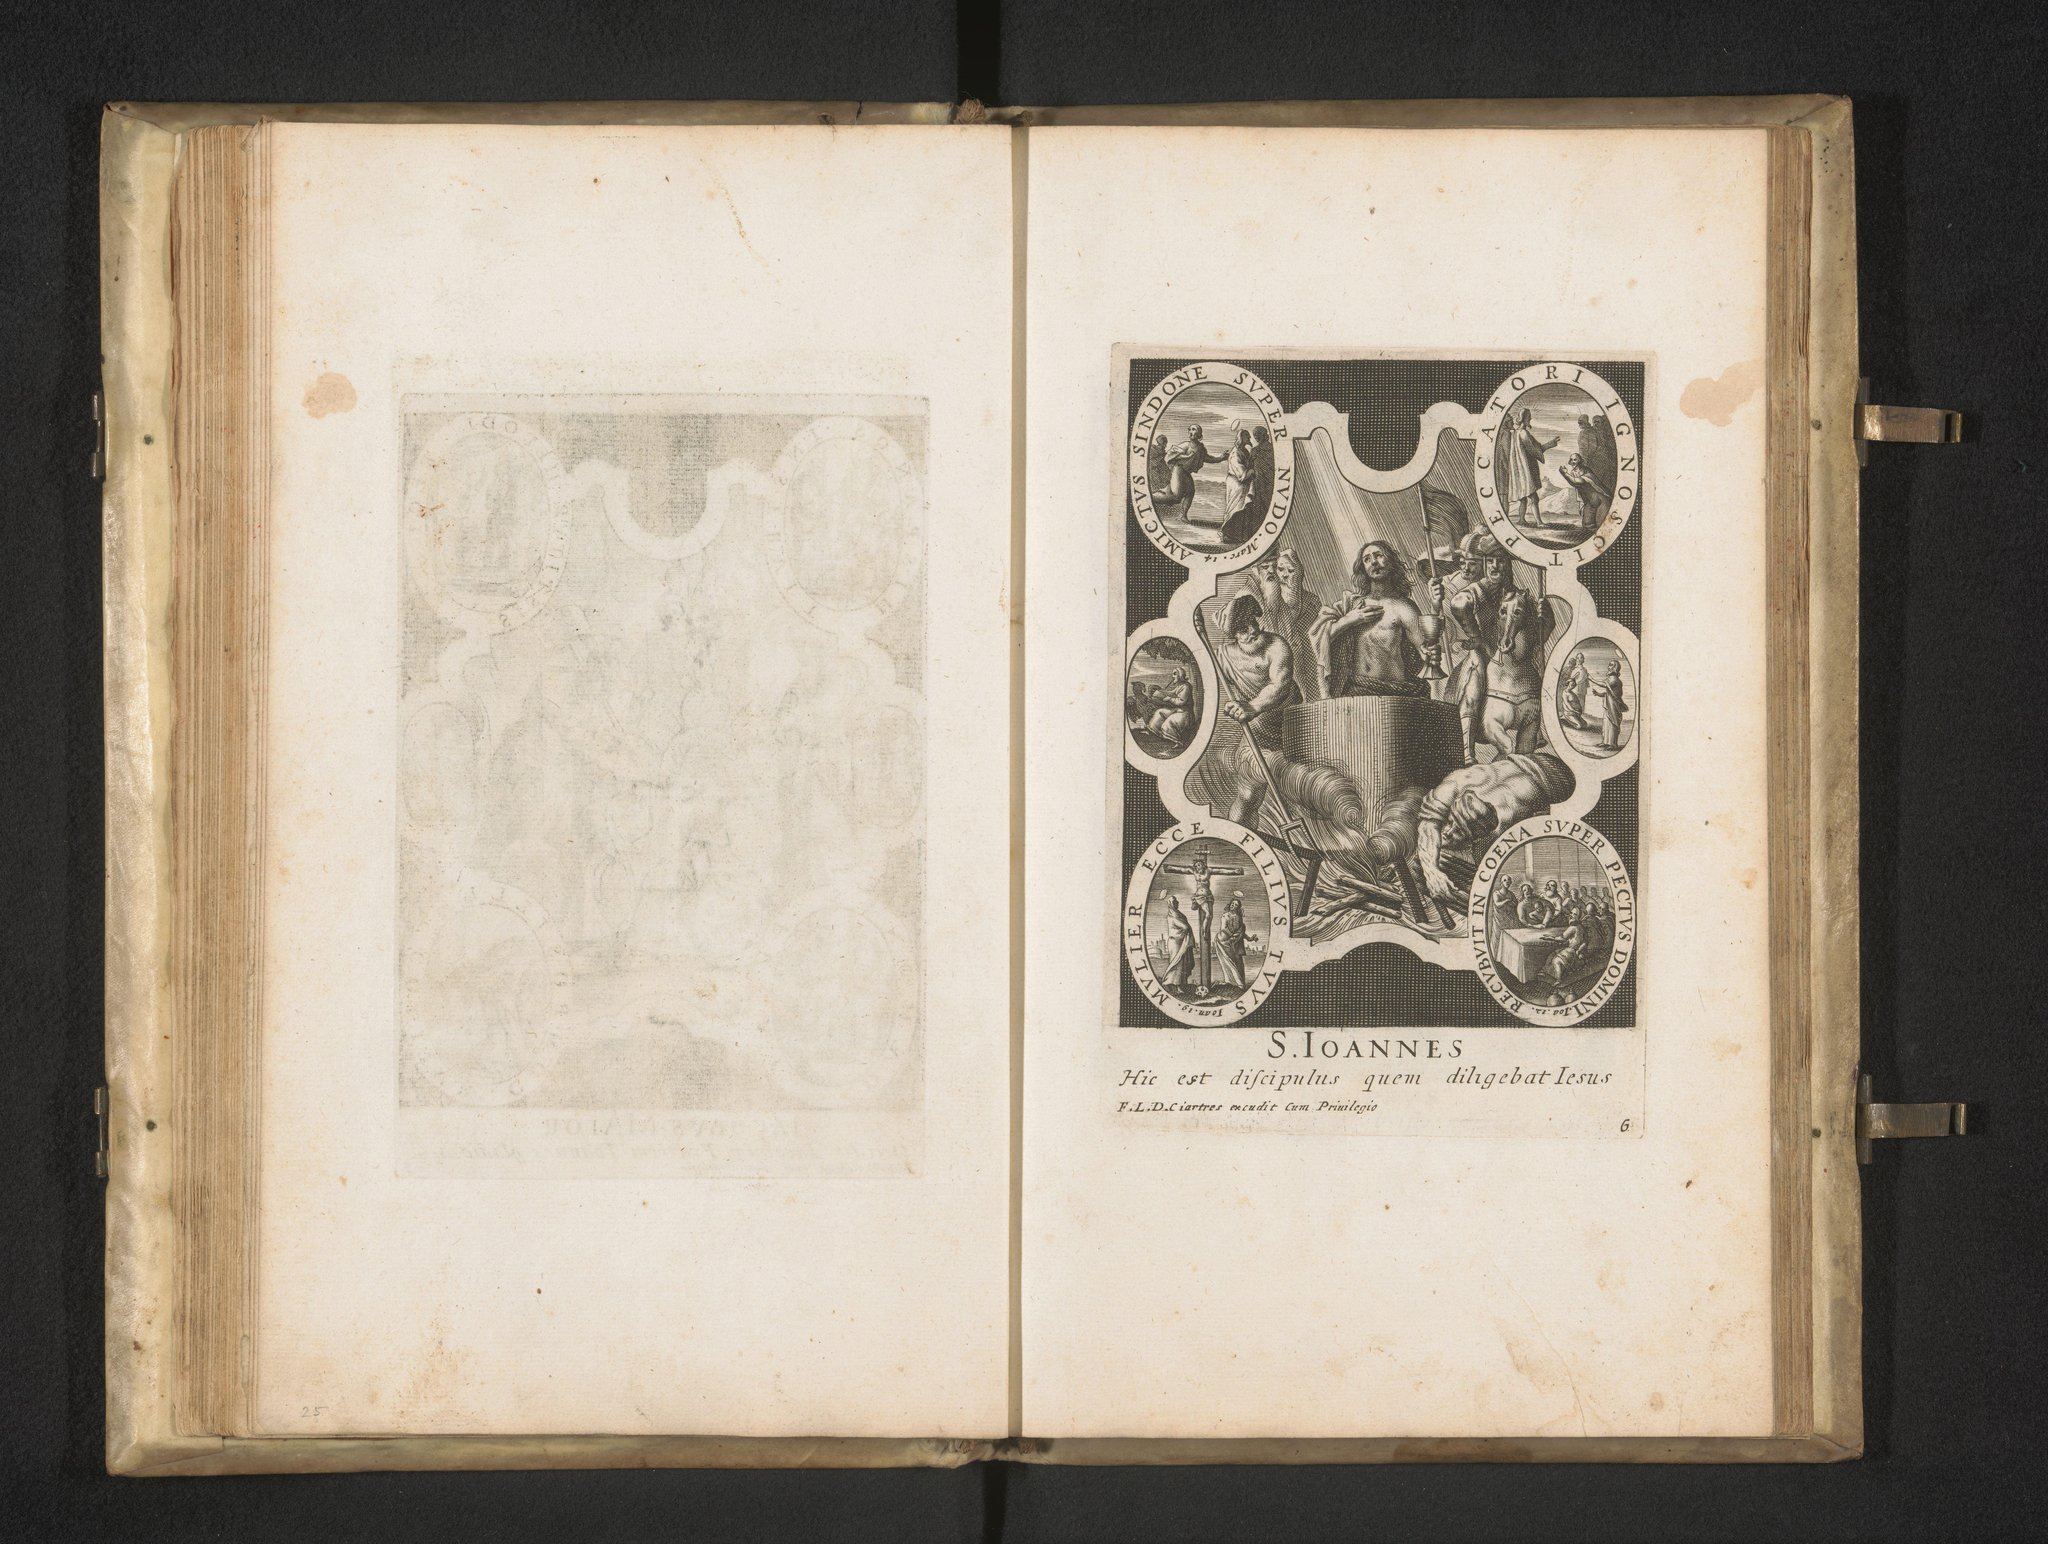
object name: print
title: S. Ioannes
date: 1610-1647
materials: paper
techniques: engraving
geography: paris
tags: martyrdom of john in front of the porta latina: he is put in a cauldron of boiling oil, but remains unharmed, the apostle john the evangelist; possible attributes: book, cauldron, chalice with snake, eagle, palm, scroll - martyrdom, suffering, misfortune, death of male saint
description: Martelaarschap van Johannes de Evangelist, in een kader met zes kleine scènes uit zijn leven. Onderdeel van een serie van twaalf voorstellingen van het martelaarschap van de apostelen. Onderdeel van een album met voornamelijk christelijke voorstellingen.